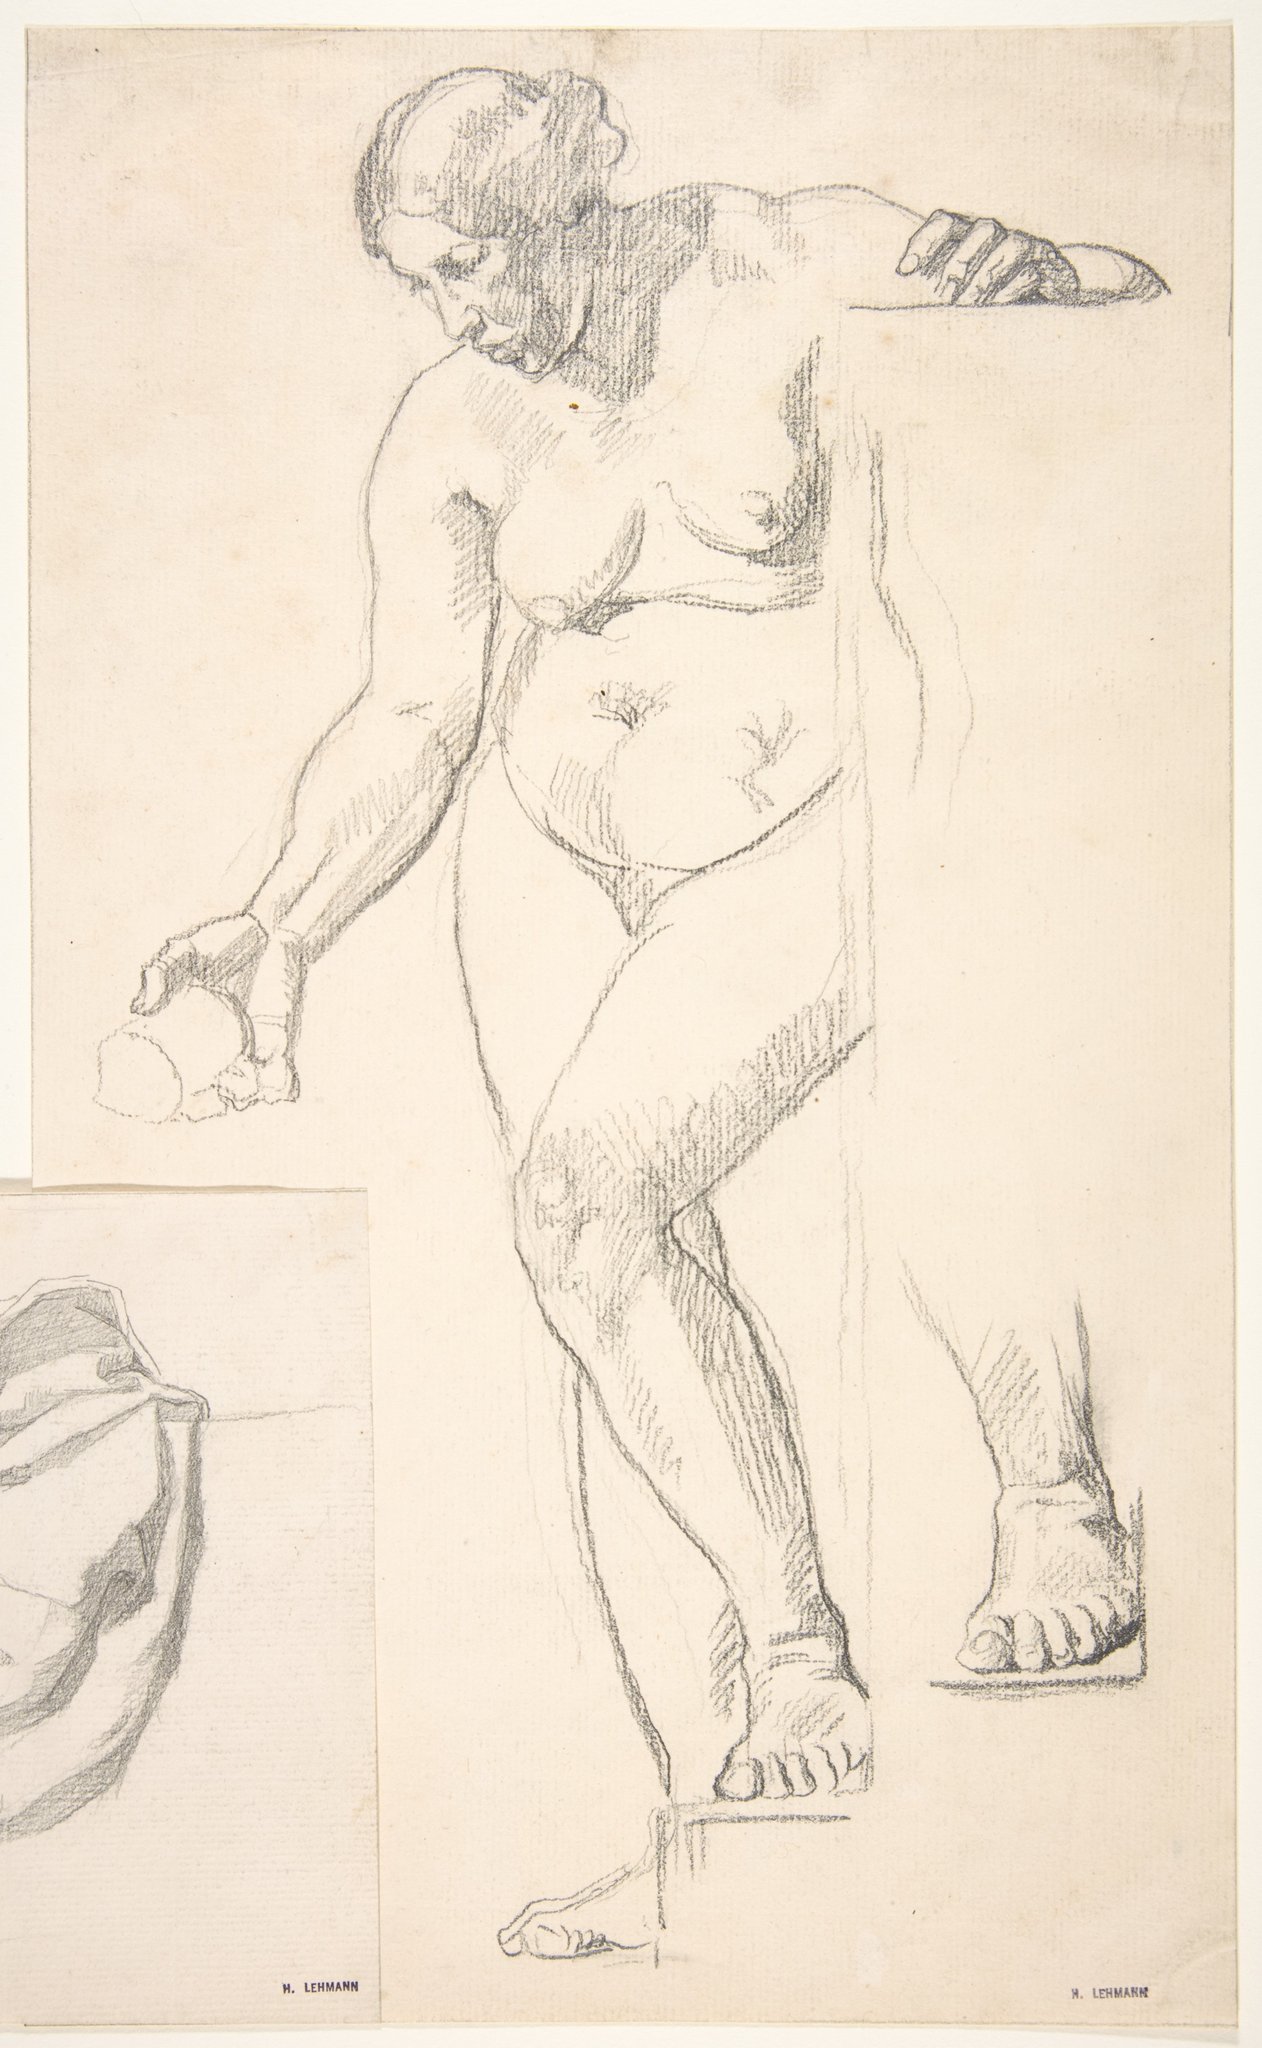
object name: drawing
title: Standing Nude Female Figure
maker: henri lehmann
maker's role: artist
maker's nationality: french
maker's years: 1814-1882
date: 1801-1900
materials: graphite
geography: france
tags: female nudes